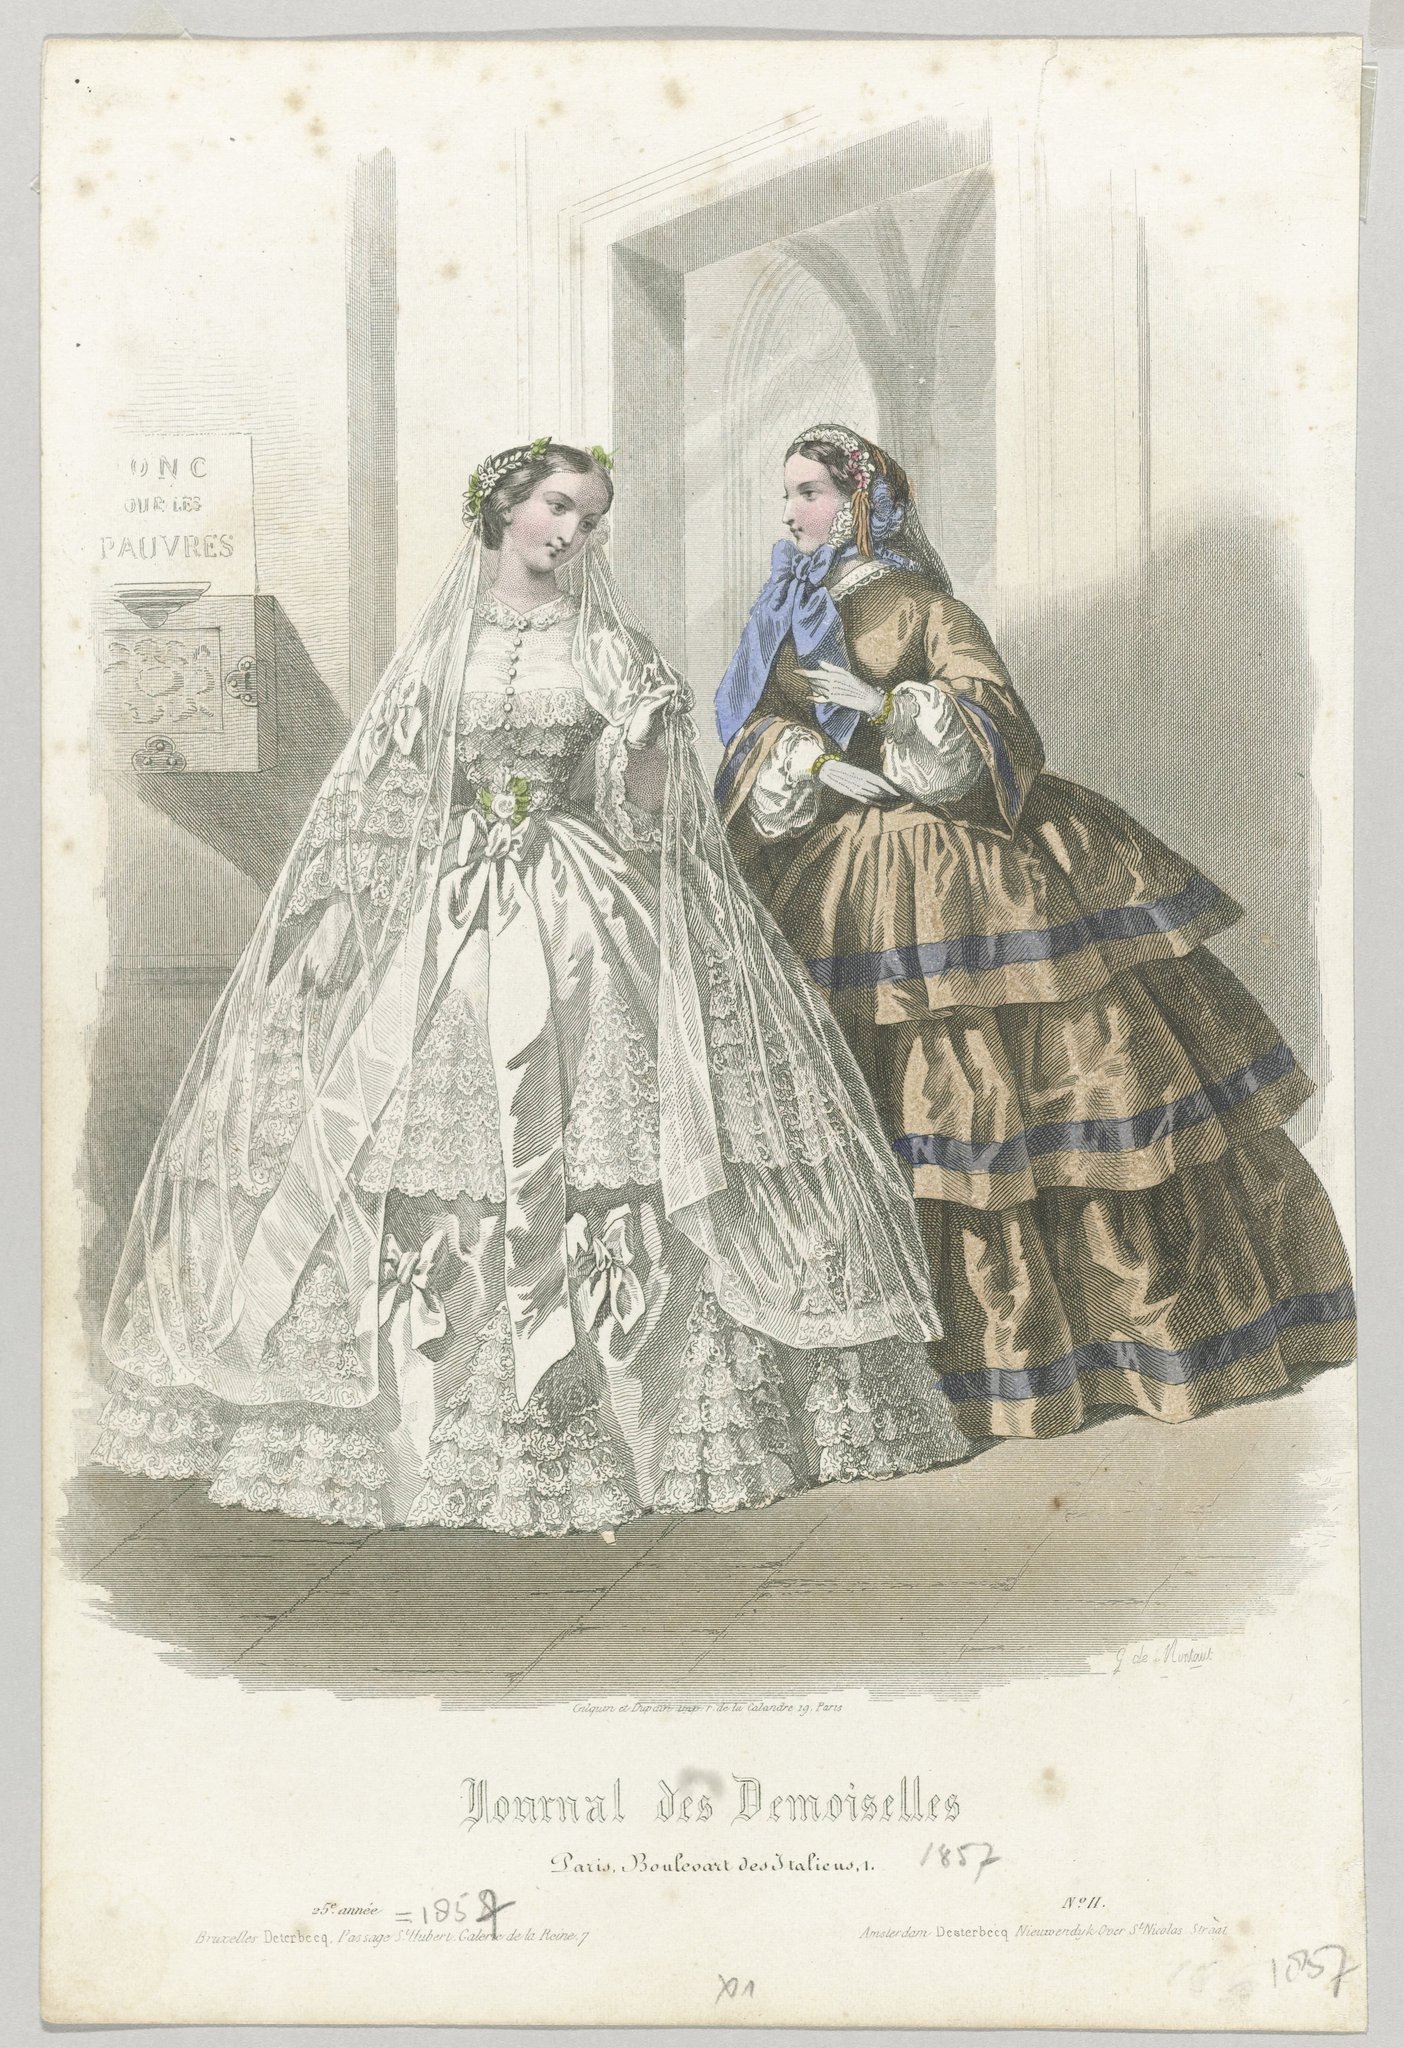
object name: fashion print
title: Journal des Demoiselles, 1857, No. 2, 25e année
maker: montaut doleron. gabriel xavier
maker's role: print maker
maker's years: 1789-1852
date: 1857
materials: paper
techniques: engraving, hand coloring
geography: paris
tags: ornamental parts of clothing (+ women's clothes), veil (+ women's clothes), gloves, mittens (short gloves) (+ women's clothes), head-gear (+ women's clothes), fashion plates, building of church, bride (in wedding-dress), bracelet, wristlet (+ women's clothes)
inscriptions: address: ‘Paris, Boulevart des Italiens, 1.’, address: ‘Bruxelles Desterbecq Passsage S.t Illubert Galerie de la Reine 7 / Amsterdam Desterbecq Nieuwendyk Over S.t Nicolas Straat’, title: ‘Journal des Demoiselles’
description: Twee vrouwen in een kerk. Links: hooggesloten bruidsjapon met gestrikt ceintuur en wijde rok versierd met kant en strikken. Op het hoofd een lange doorzichtige sluier. Rechts: bruine japon met wijd uitlopende mouwen en witte poffende ondermouwen. Wijde rok met drie gerimpelde stroken stof met blauwe strepen. Op het hoofd een bruine hoed met blauwe striklinten. Armbanden om beide polsen. Prent uit het modetijdschrift Journal des Demoiselles (1833 -1922).